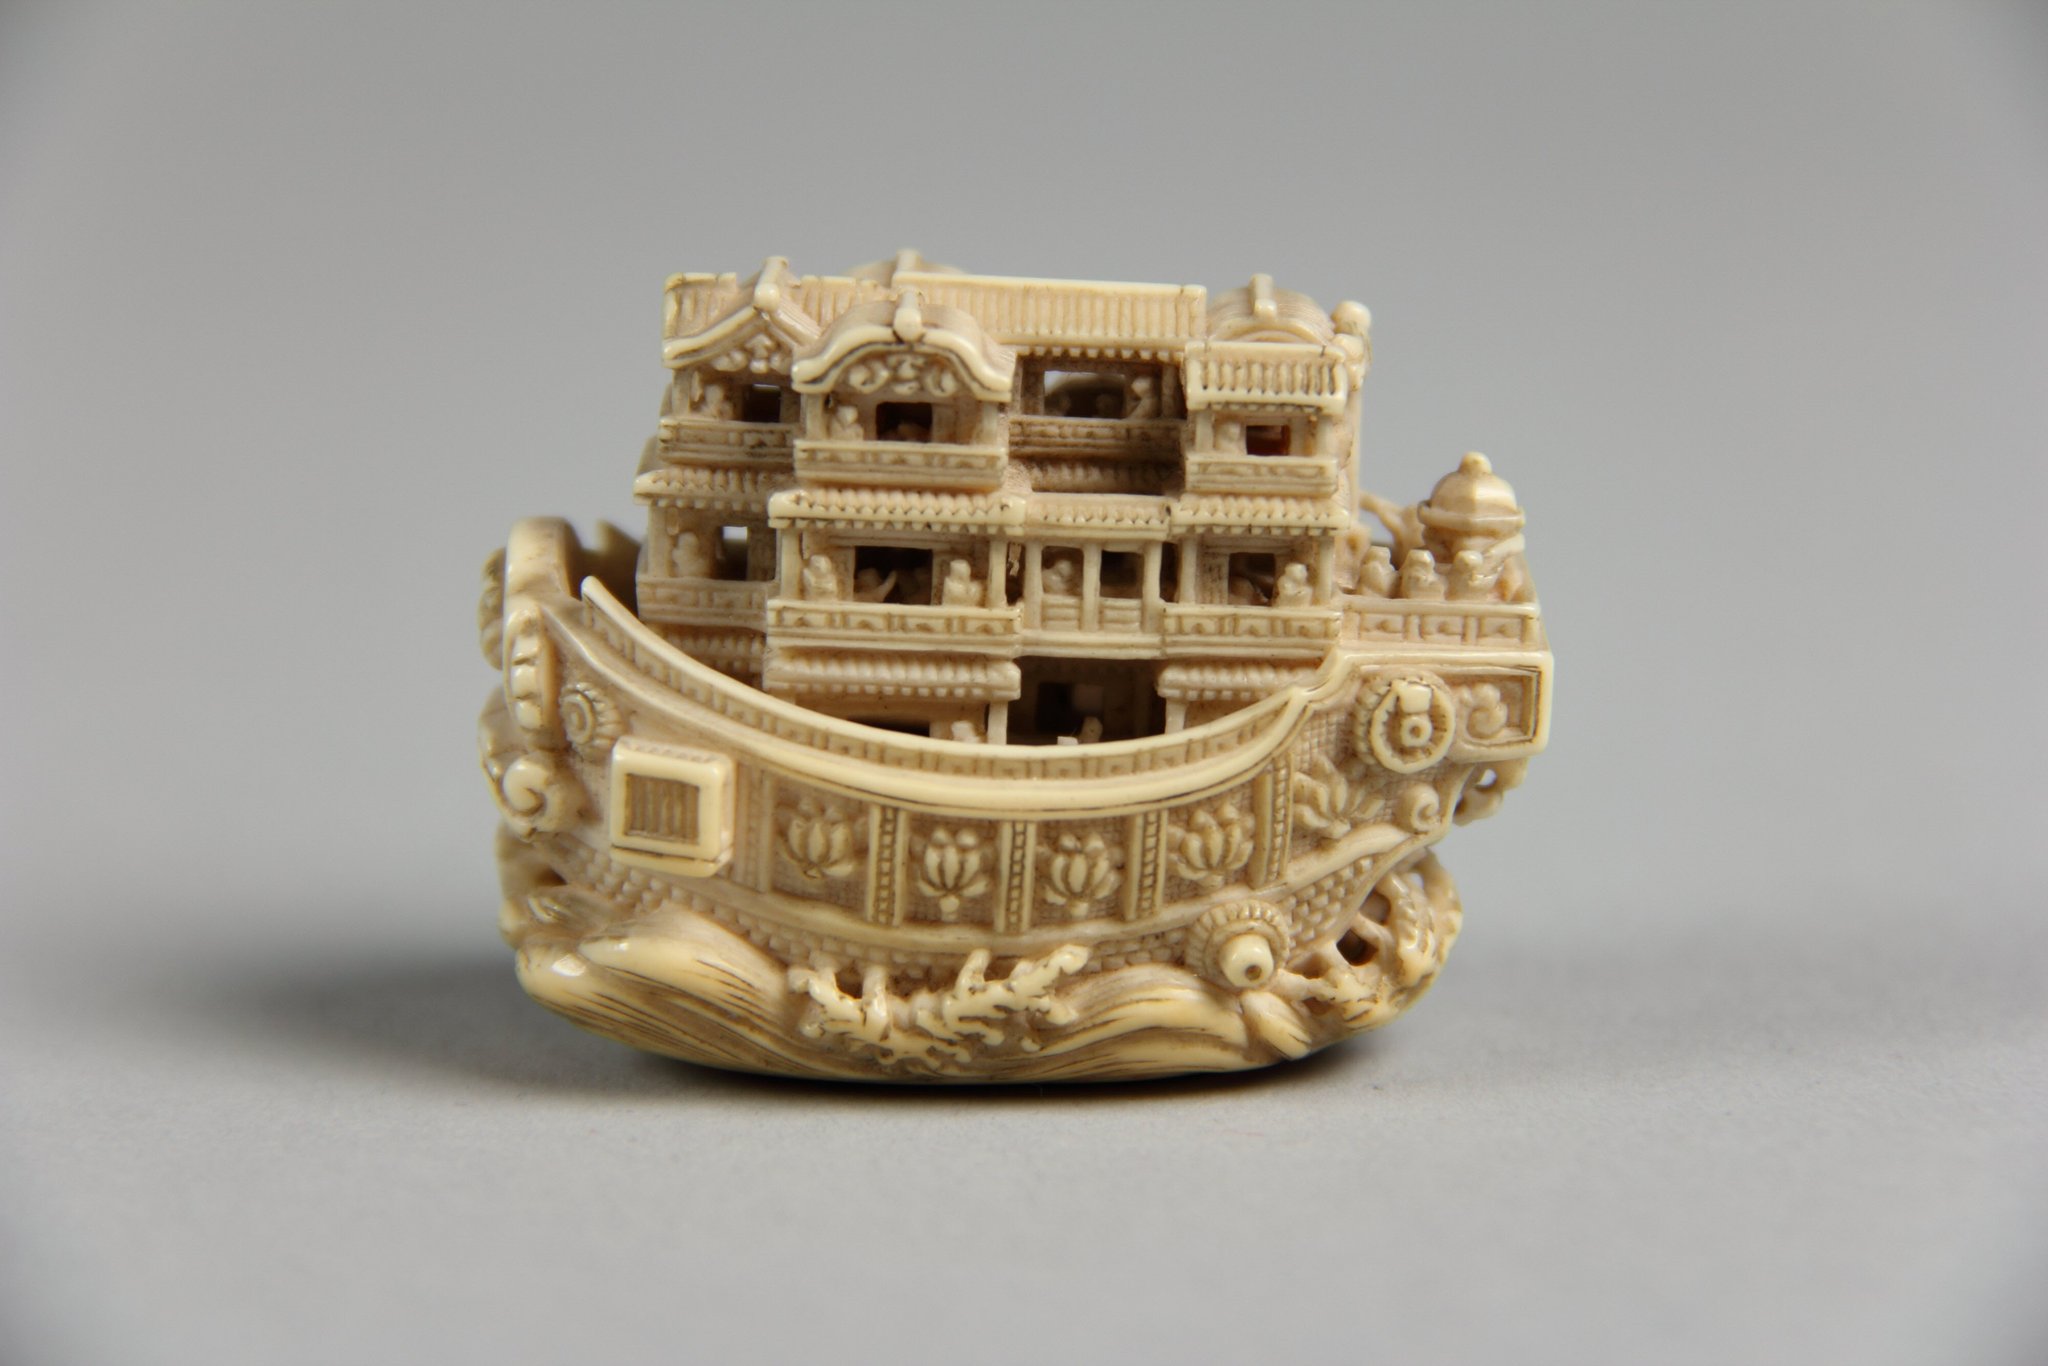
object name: netsuke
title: Pleasure Boat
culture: japanese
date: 1801-1900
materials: ivory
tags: boats